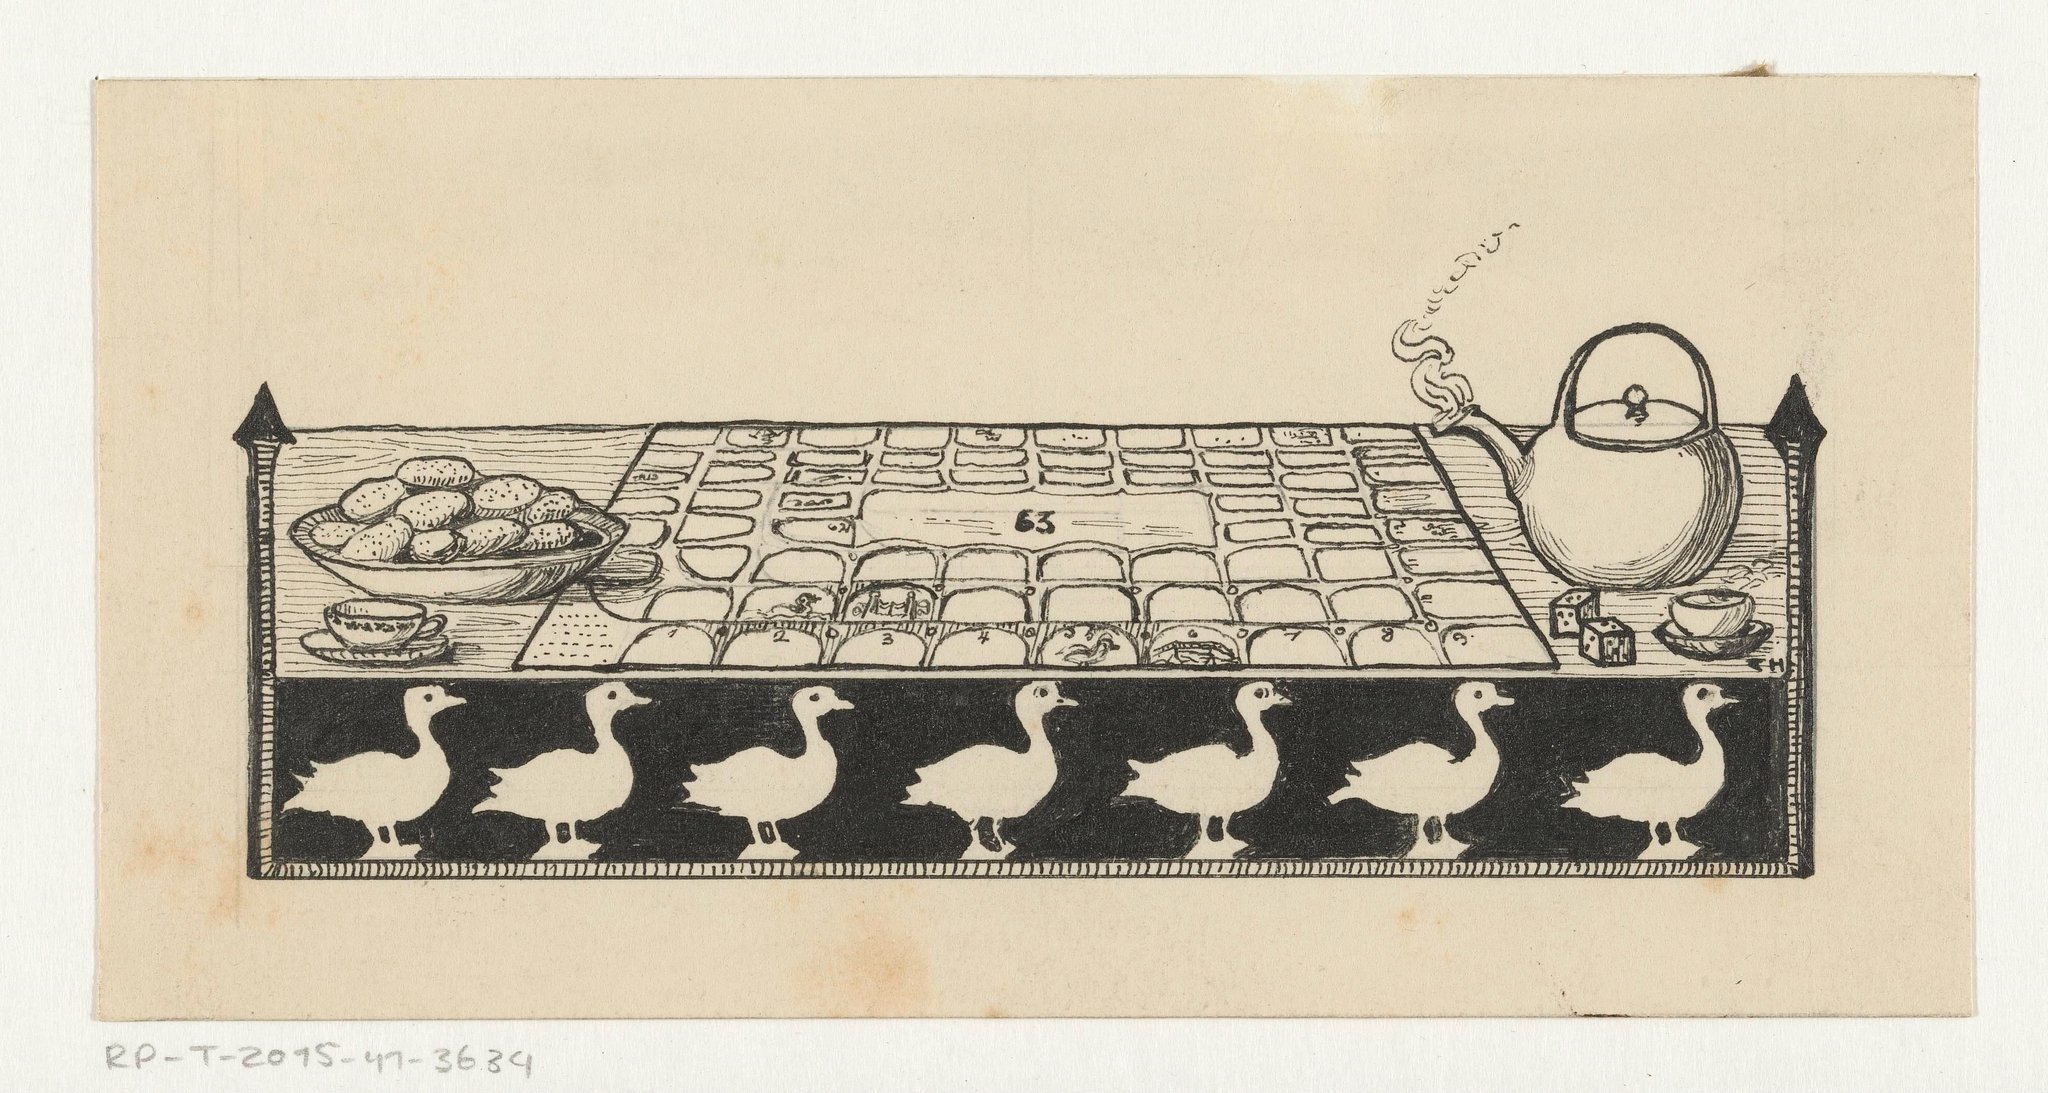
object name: drawing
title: Ganzenbordspel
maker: Anonymous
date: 1890-1940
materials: ink, paper, pencil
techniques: pen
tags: goose-game, tea-pot; samovar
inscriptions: collector's mark: Lugt 2228a, signature: ‘CH’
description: Op een tafel ligt een ganzenbordspel. Ernaast staan een dampende pot thee, theekopjes en een schaal met koek. Onderaan een decoratief kader met ganzenmotief.